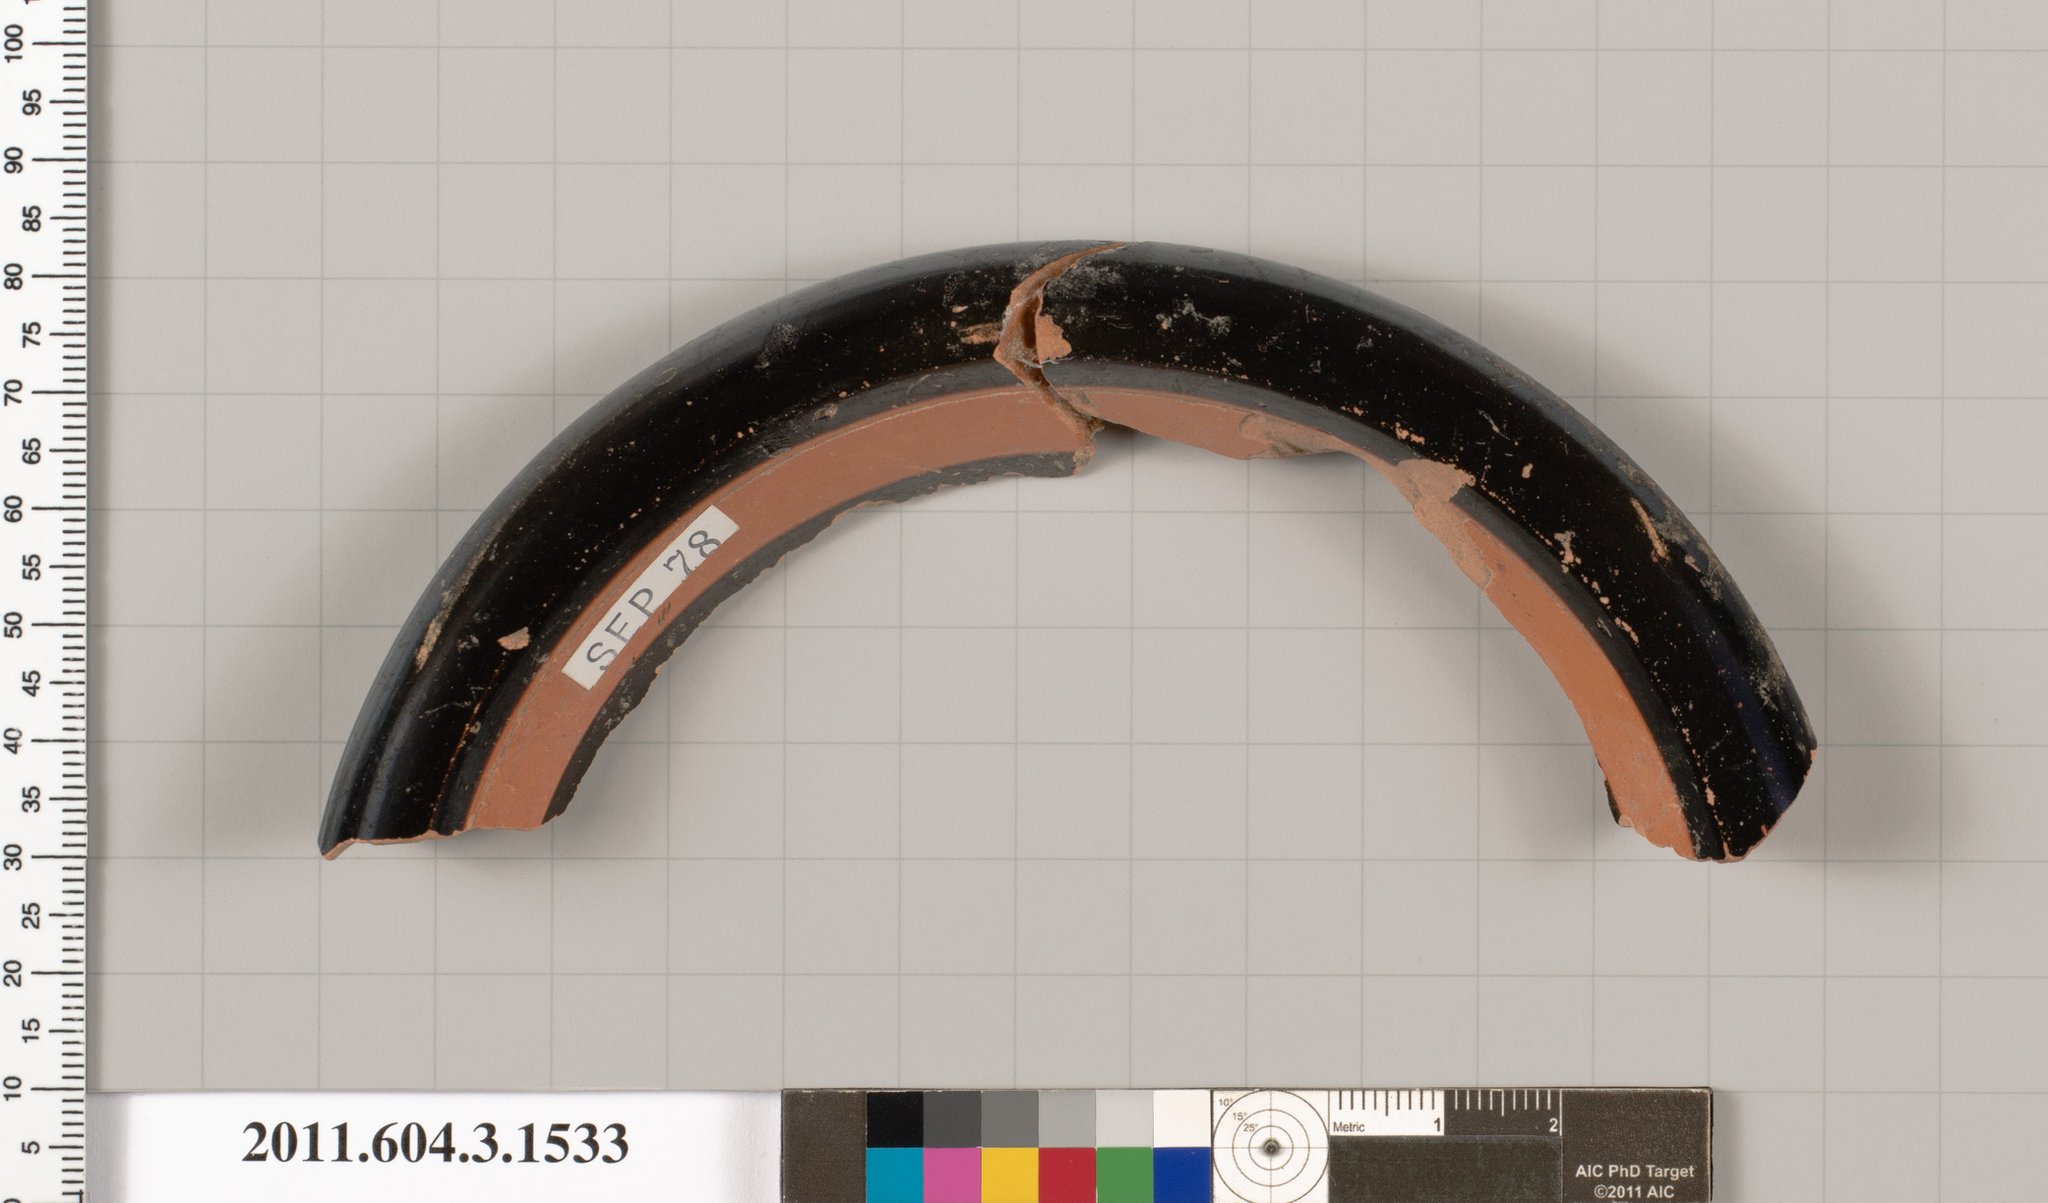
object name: skyphos fragment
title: Terracotta fragment of a skyphos (deep drinking cup)?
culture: greek, attic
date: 600-401 BCE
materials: terracotta